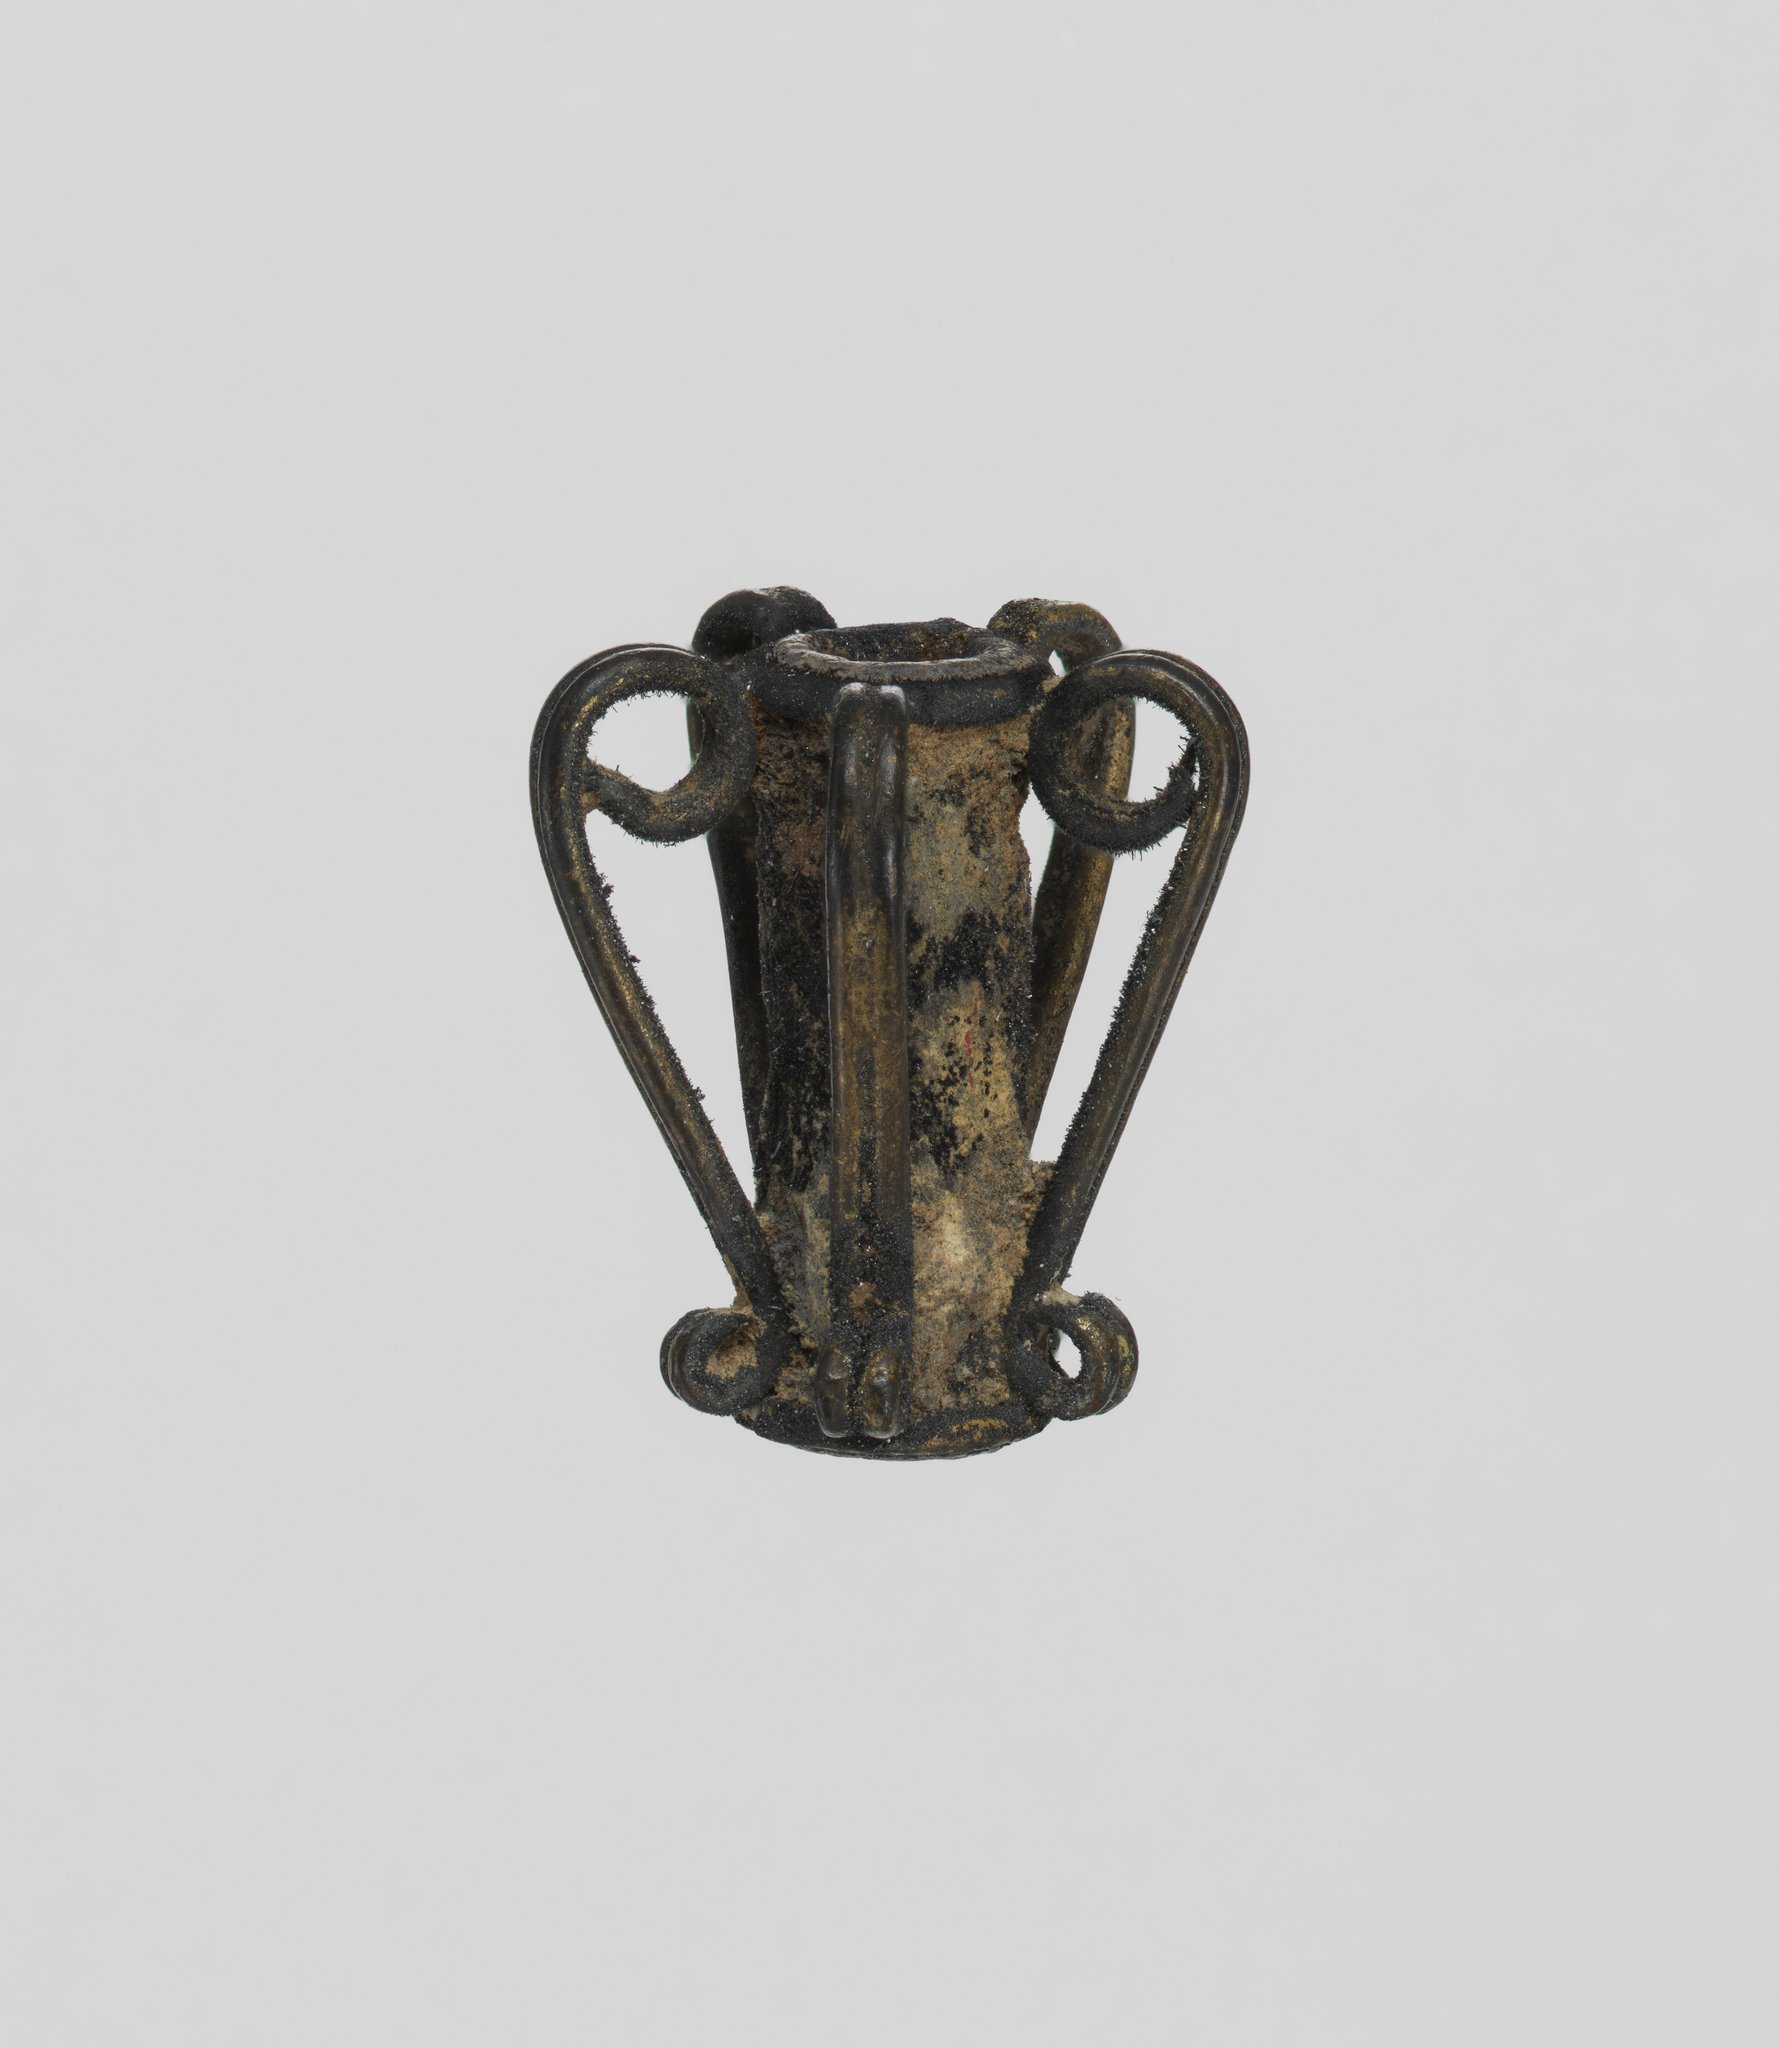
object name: bead, scroll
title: Bead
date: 1070-343 BCE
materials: gold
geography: egypt